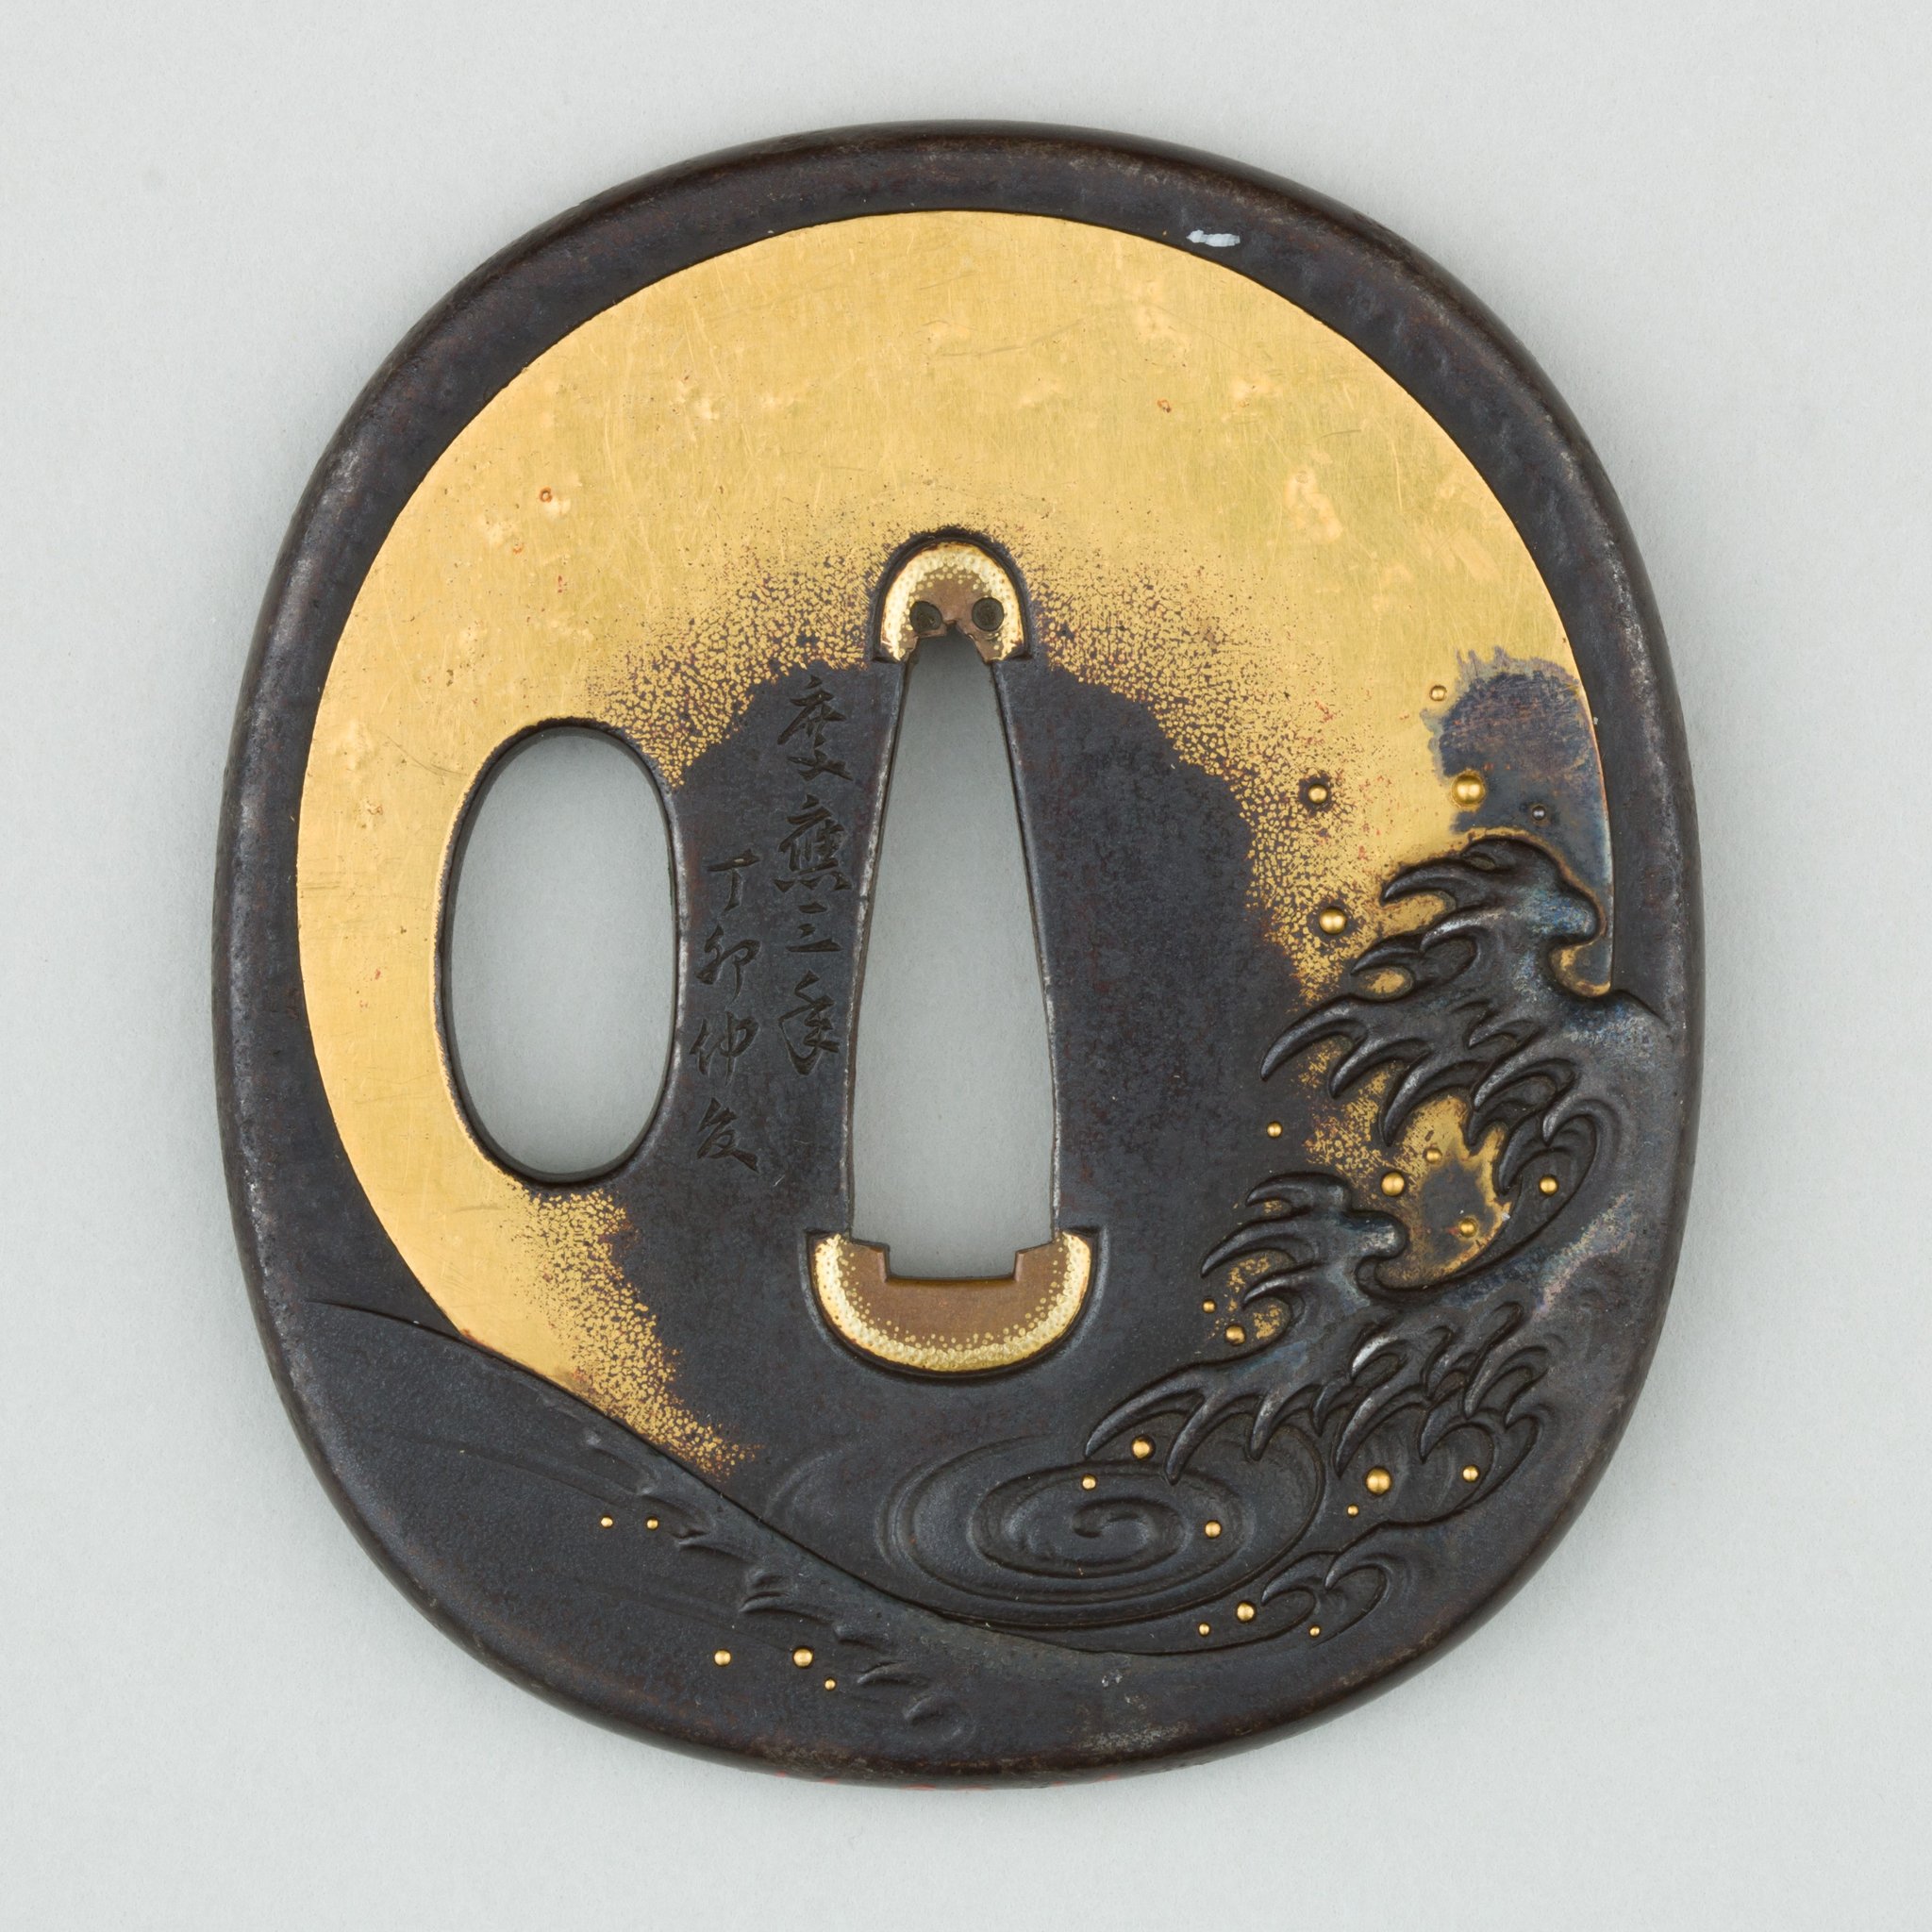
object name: sword guard tsuba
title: Sword Guard (Tsuba)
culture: japanese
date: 1867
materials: copper, gold, iron, silver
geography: japan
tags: waves